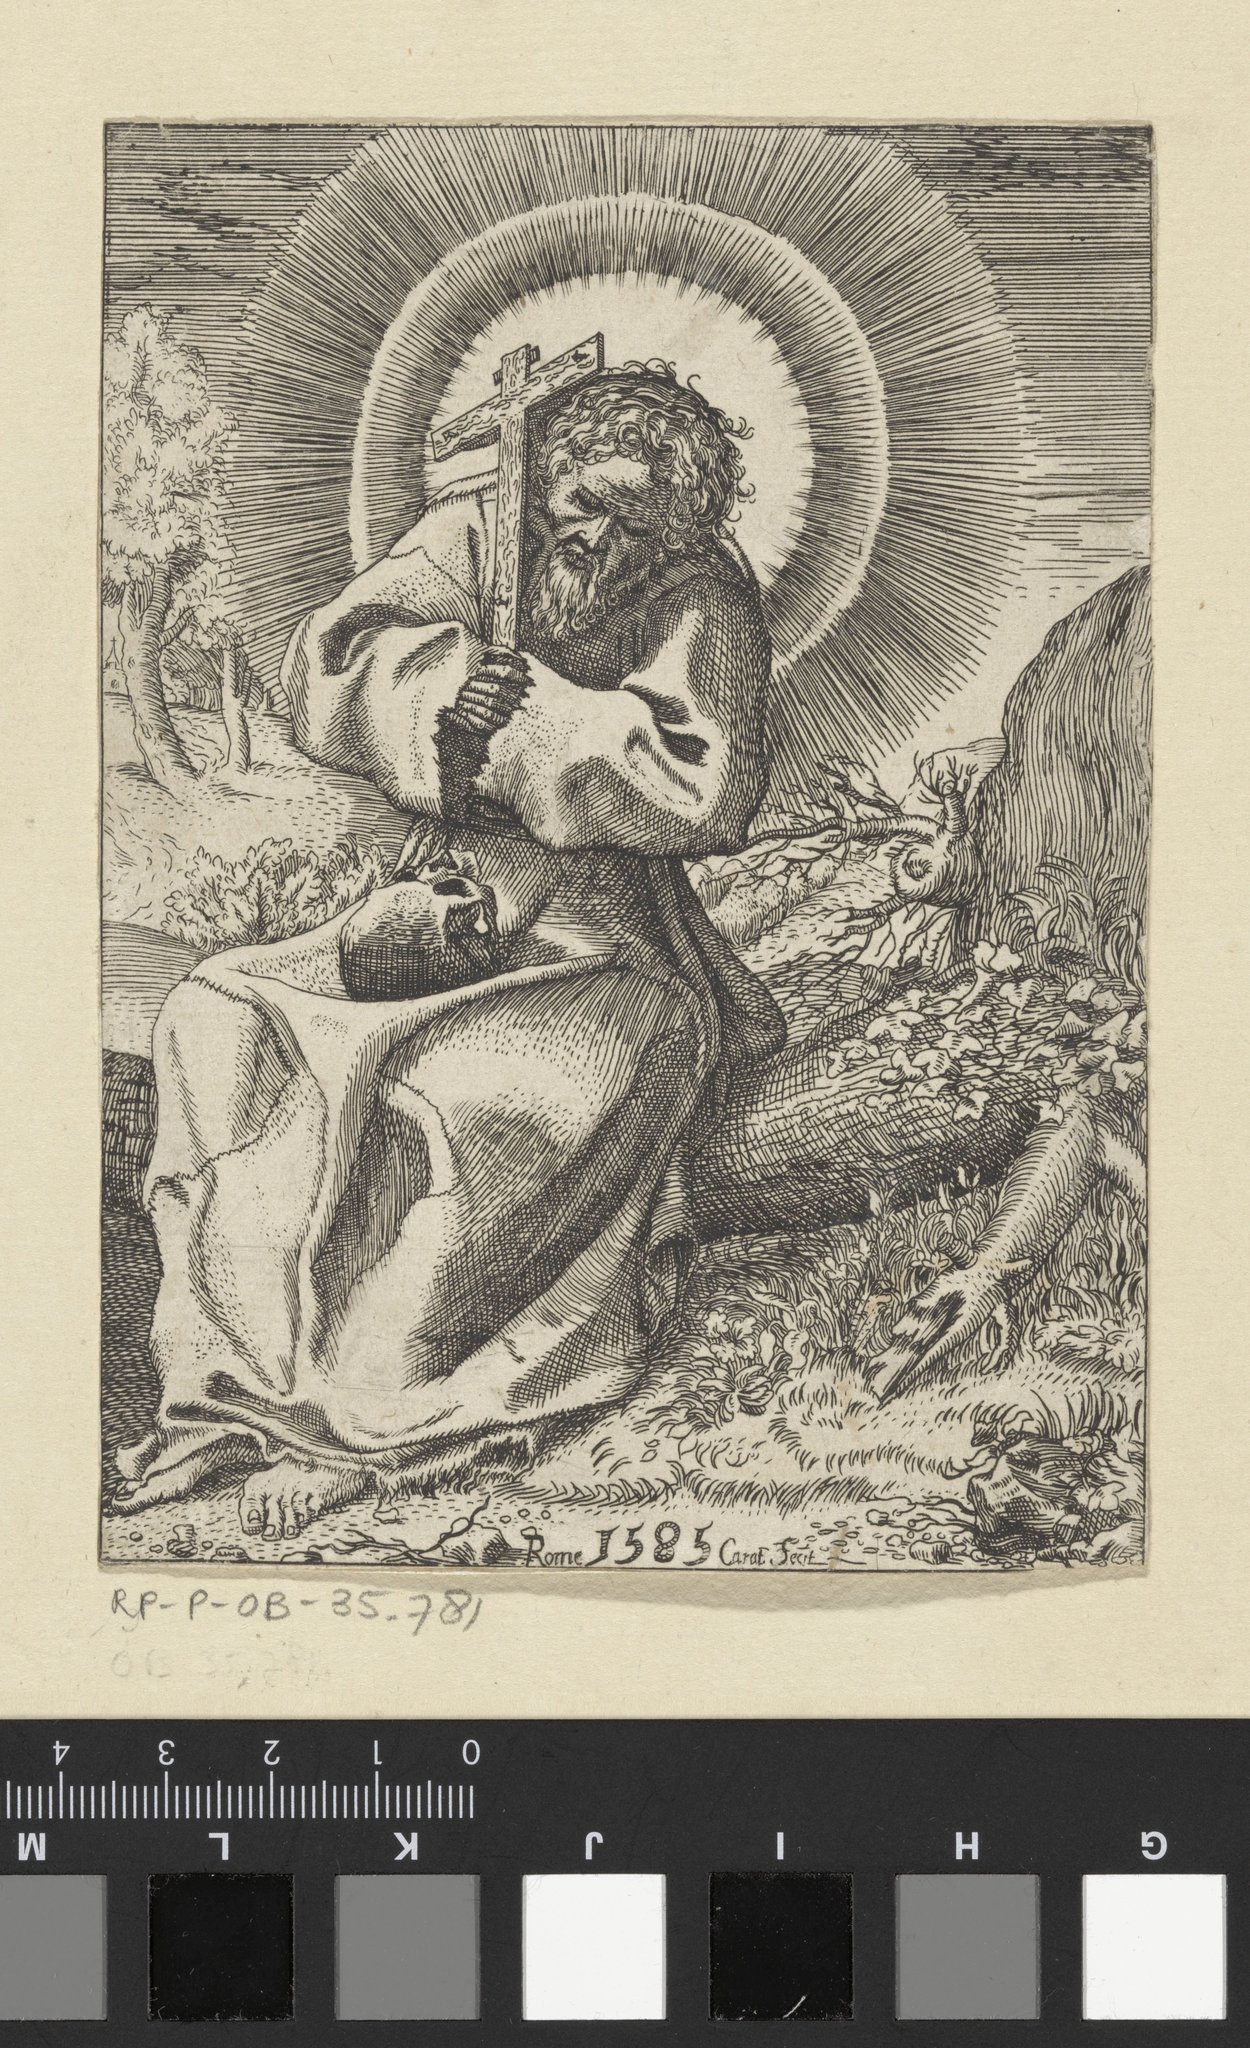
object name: print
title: De heilige Franciscus van Assisi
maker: Anonymous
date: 1585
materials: paper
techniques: engraving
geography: italy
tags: founder of the order of friars minor (franciscans), francis(cus) of assisi; possible attributes: book, crucifix, lily, skull, stigmata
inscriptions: collector's mark: Lugt 240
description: De heilige Franciscus in gebed in een landschap. In zijn handen houdt hij een crucifix. Op zijn schoot ligt een schedel.